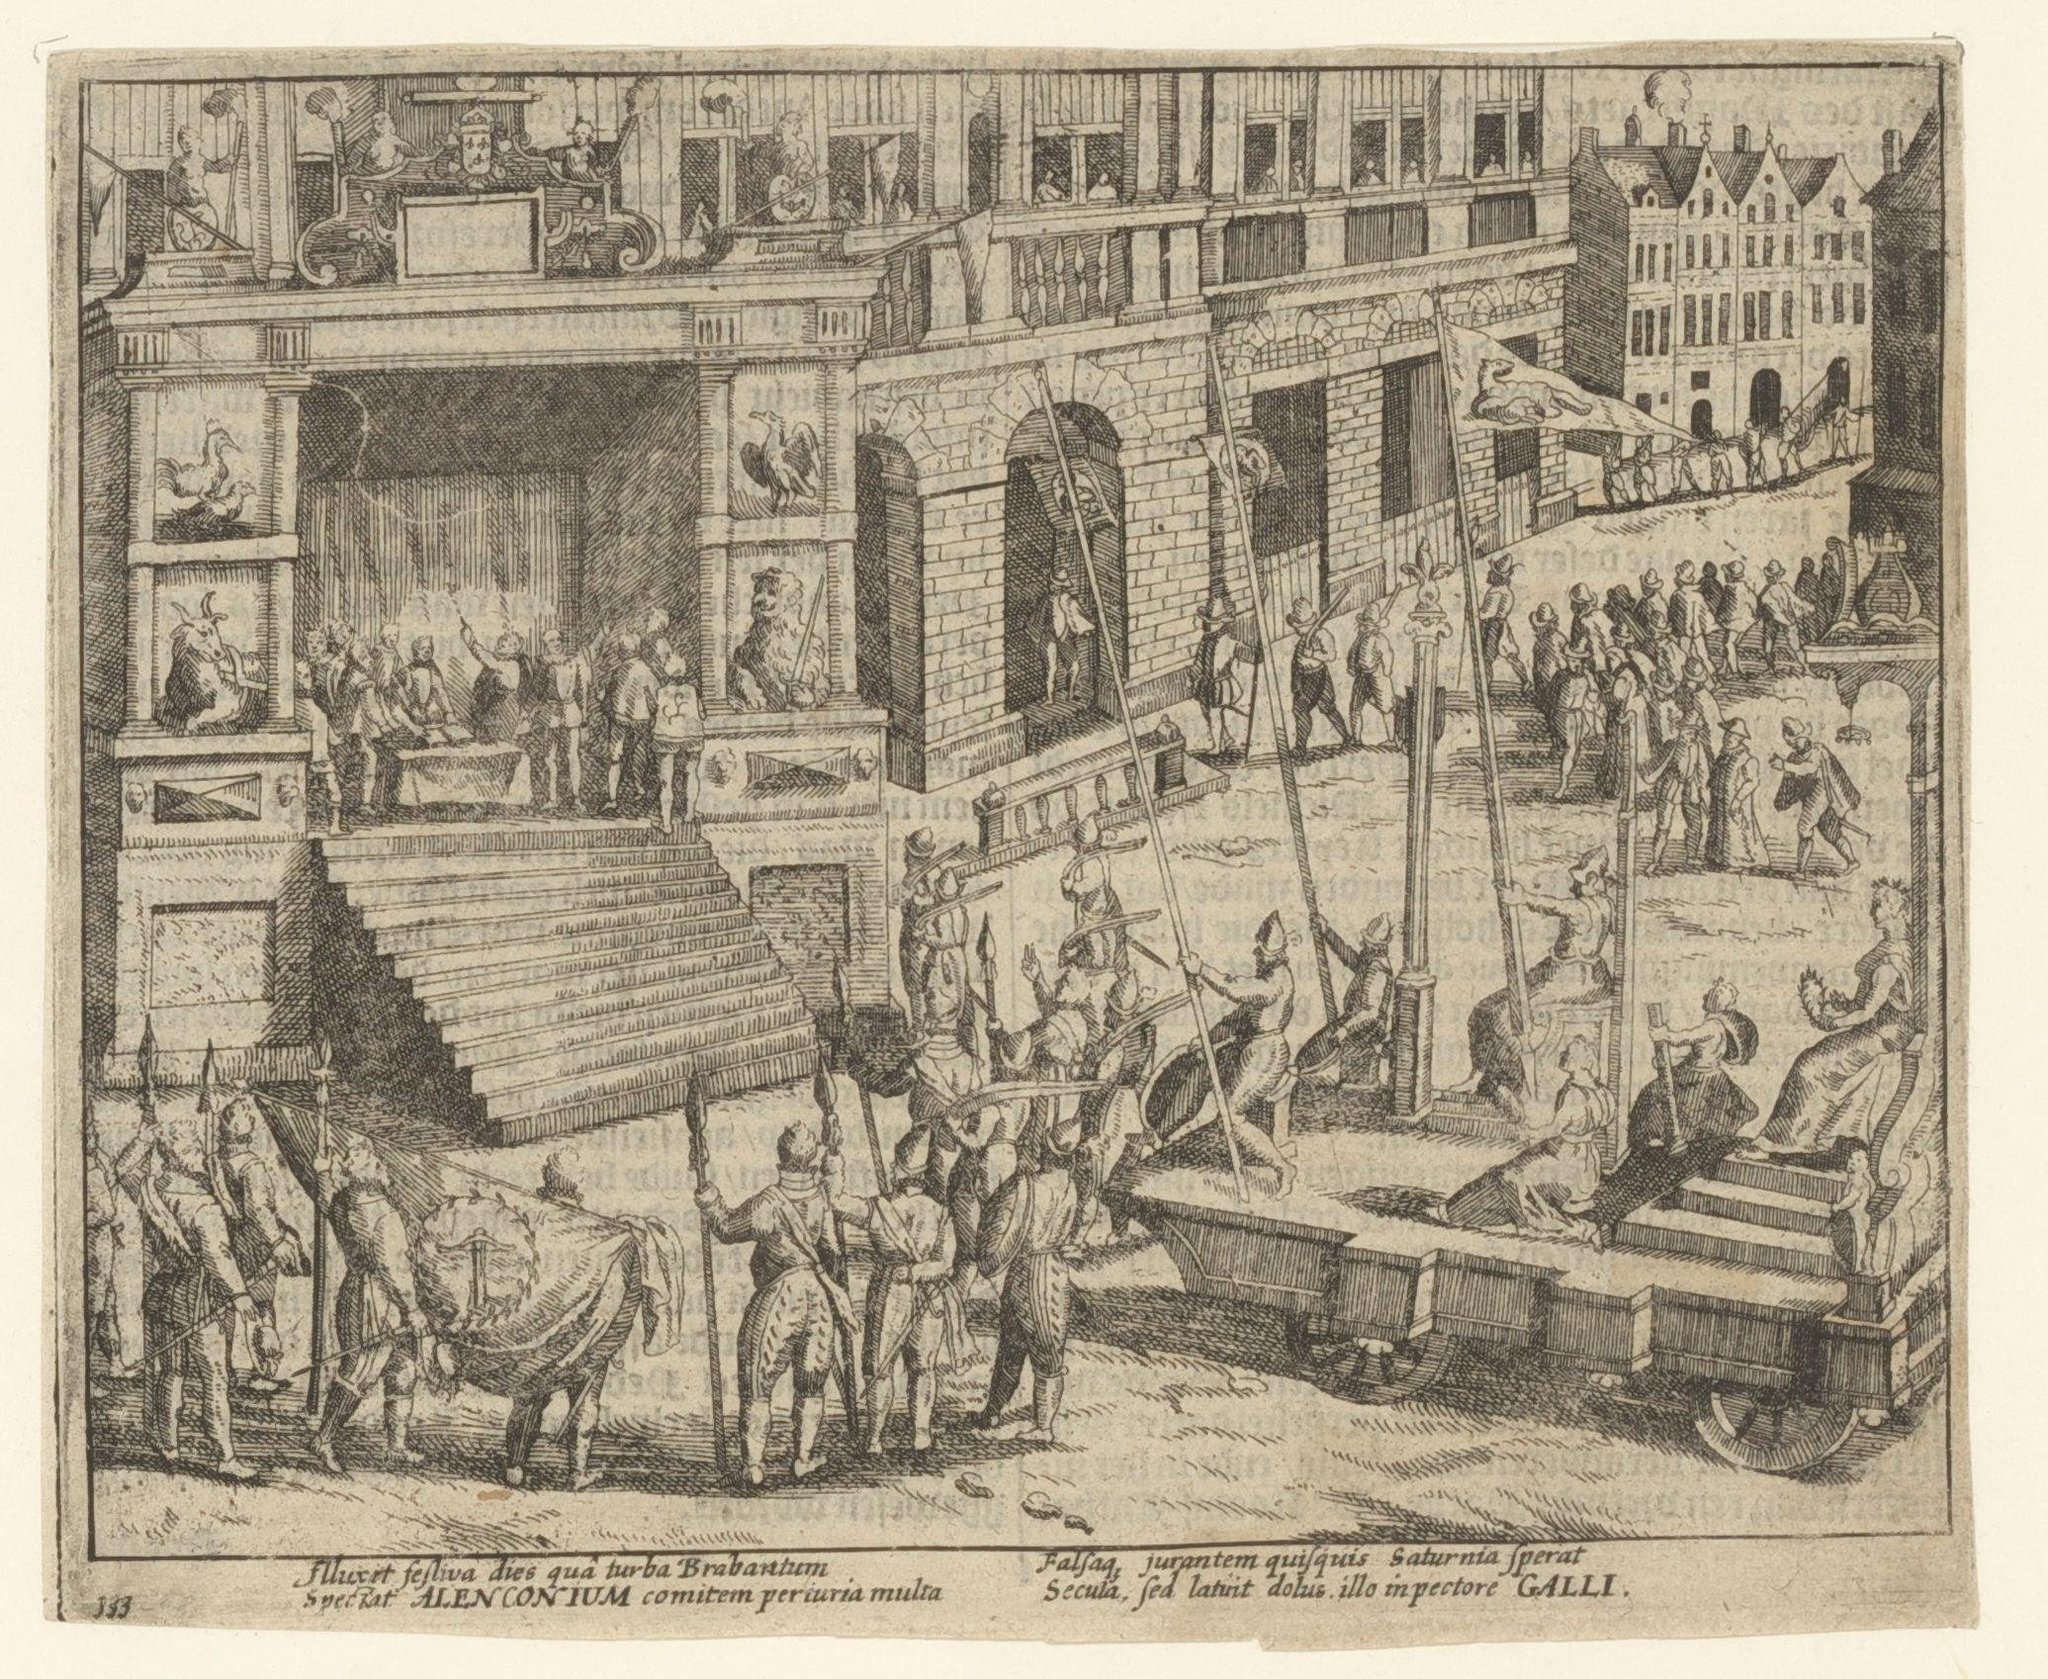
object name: history print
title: De eedsaflegging op de Grote Markt, 1582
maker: Anonymous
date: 1613-1615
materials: paper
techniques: etching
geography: northern netherlands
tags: françois-hercule de valois (hertog van anjou), new ruler taking the oath, float ~ triumph, triumphal entry and public reception, pageant, 'entrée solennelle', 'joyeuse entrée', swearing an oath (with two fingers raised)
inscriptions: collector's mark, collector's mark: Lugt 1641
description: De eedsaflegging door de hertog van Anjou aan de stad Antwerpen op de Grote Markt voor het stadhuis, 22 februari 1582. Rechts een praalwagen met allegorische figuren. Met onderschrift van 4 regels in het Latijn. Genummerd 133. Bedrukt op achterzijde met tekst in het Nederlands. Onderwerpsrubrieken binnen de Atlas Zeden en Gewoonten: Krijgswezen; prenten van Baudart. 80j. oorlog.